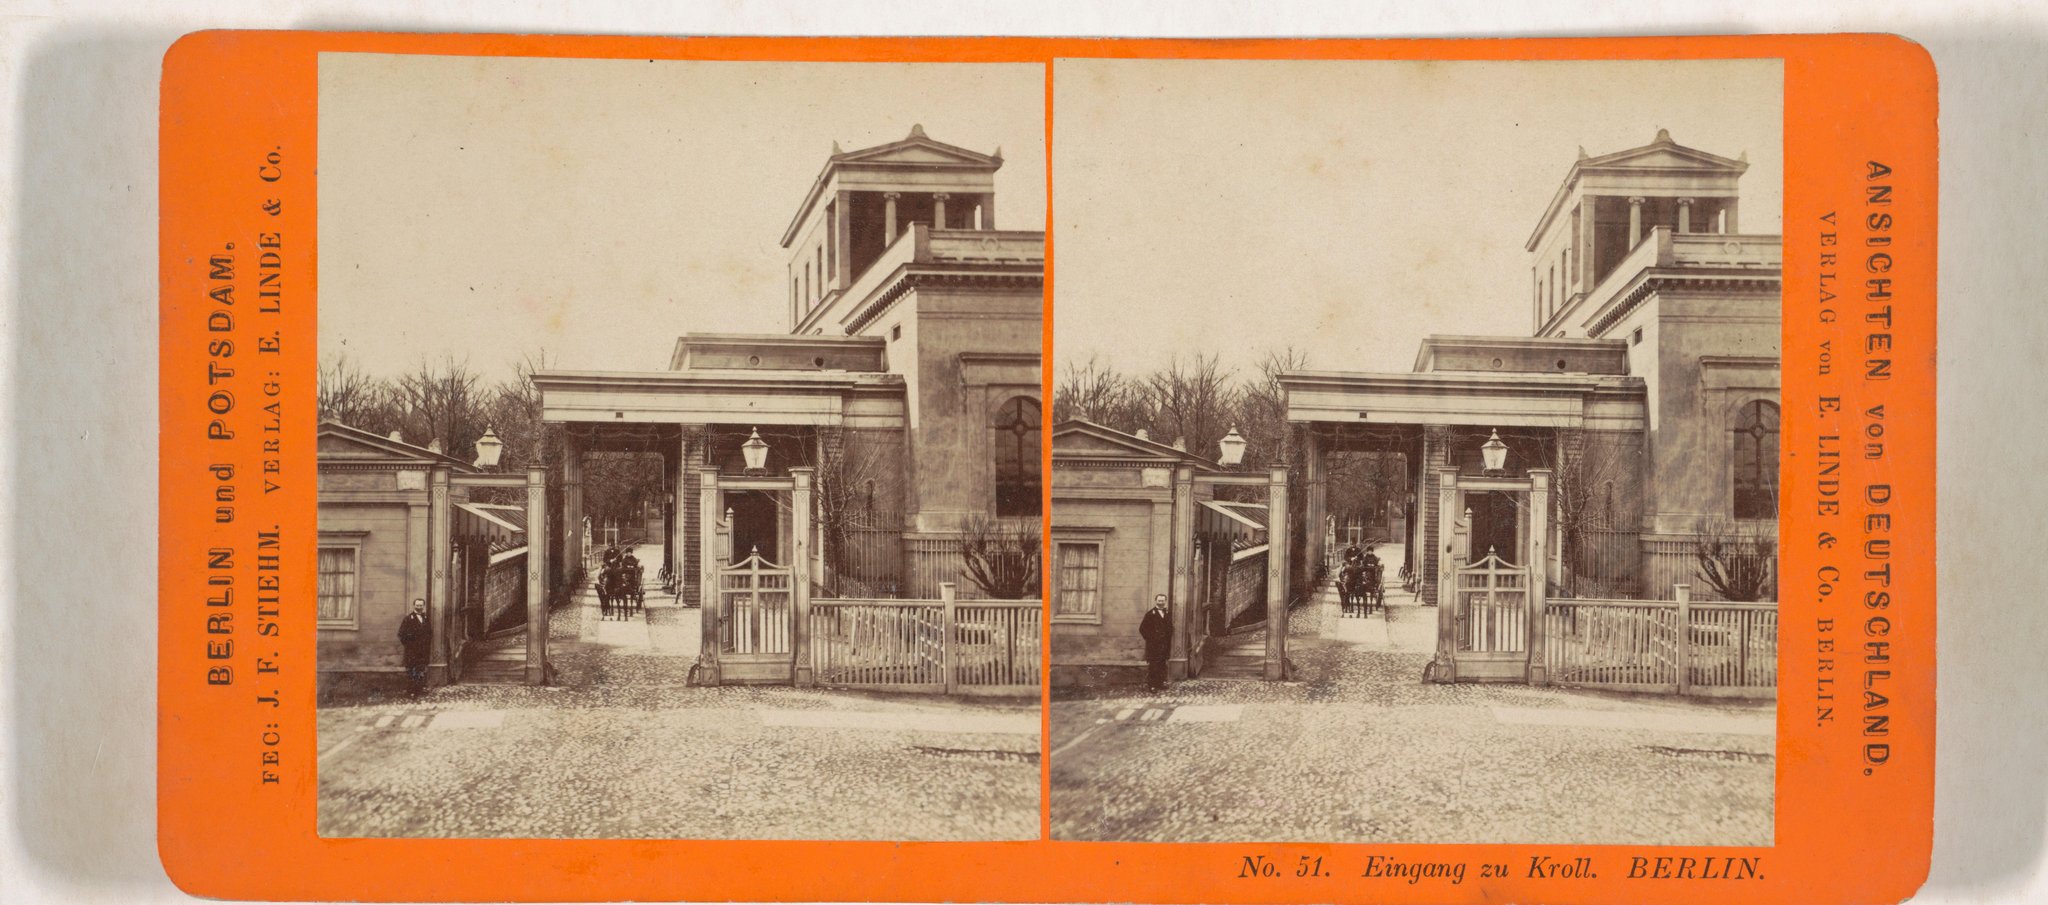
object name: stereograph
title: Entree van de Kroll-Oper, Berlijn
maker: johann friedrich stiehm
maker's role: fotograaf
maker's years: 1826-1902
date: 1868-1870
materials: cardboard, paper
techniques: albumen print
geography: berlin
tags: opera house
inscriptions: number: ‘No. 51.’